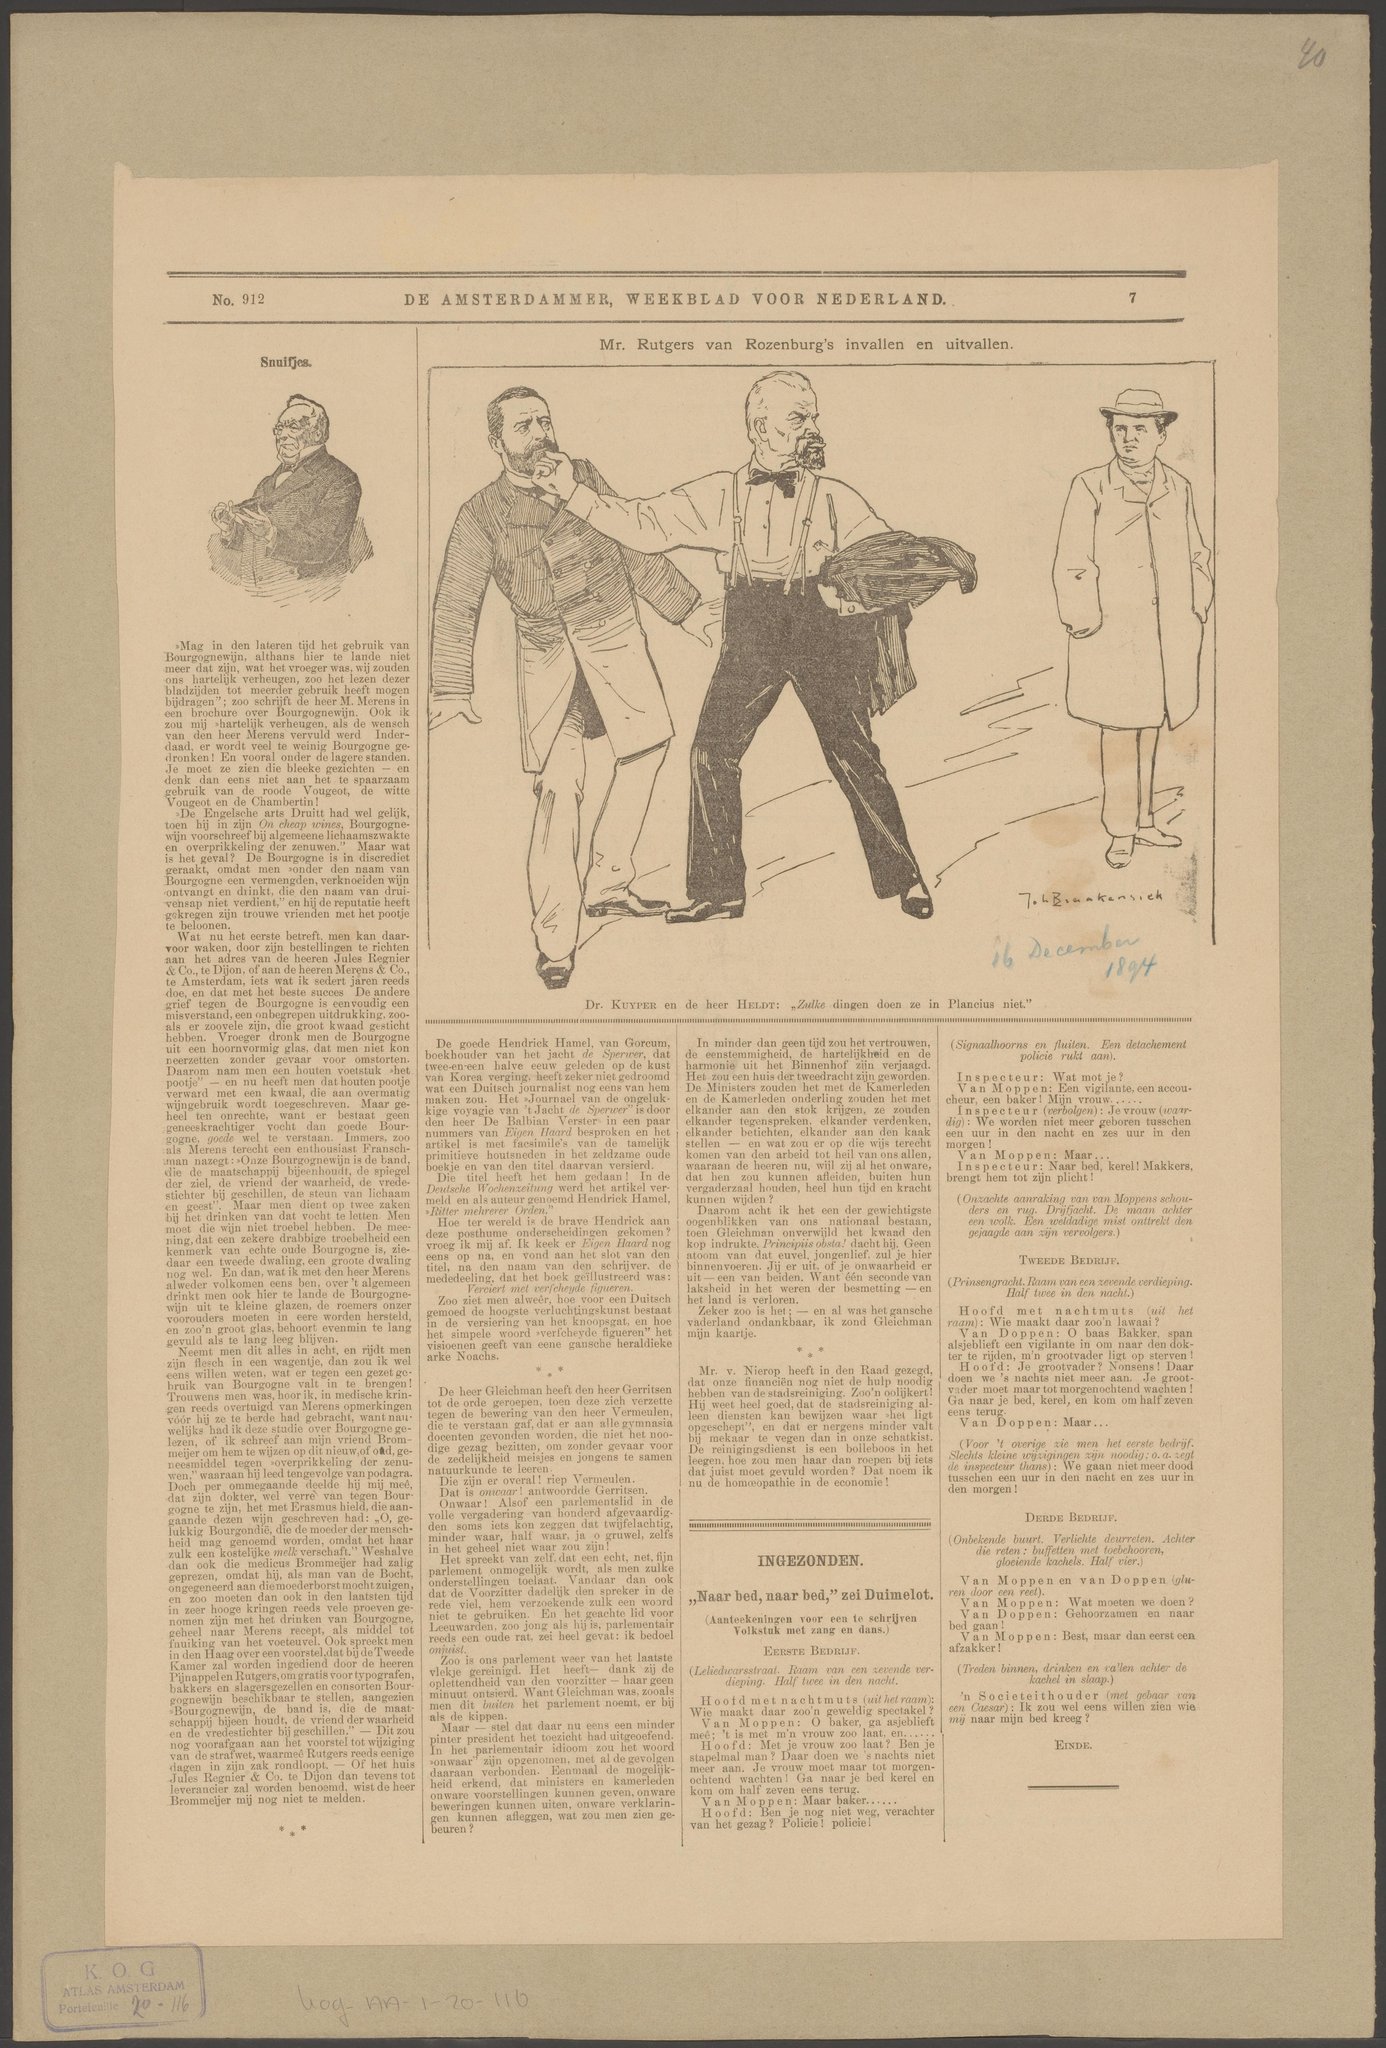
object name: photomechanical print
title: Mr. Rutgers van Rozenburg's invallen en uitvallen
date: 1894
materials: paper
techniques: letterpress printing, line block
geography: netherlands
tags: amsterdam, the hague, abraham kuyper, arnhem, furniture worker, politician, e.g. party leader, political caricatures and satires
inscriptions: collector's mark: Lugt 1641b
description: Onderwerpsrubriek binnen de Atlas Amsterdam: Verkiezingen Gemeenteraad.